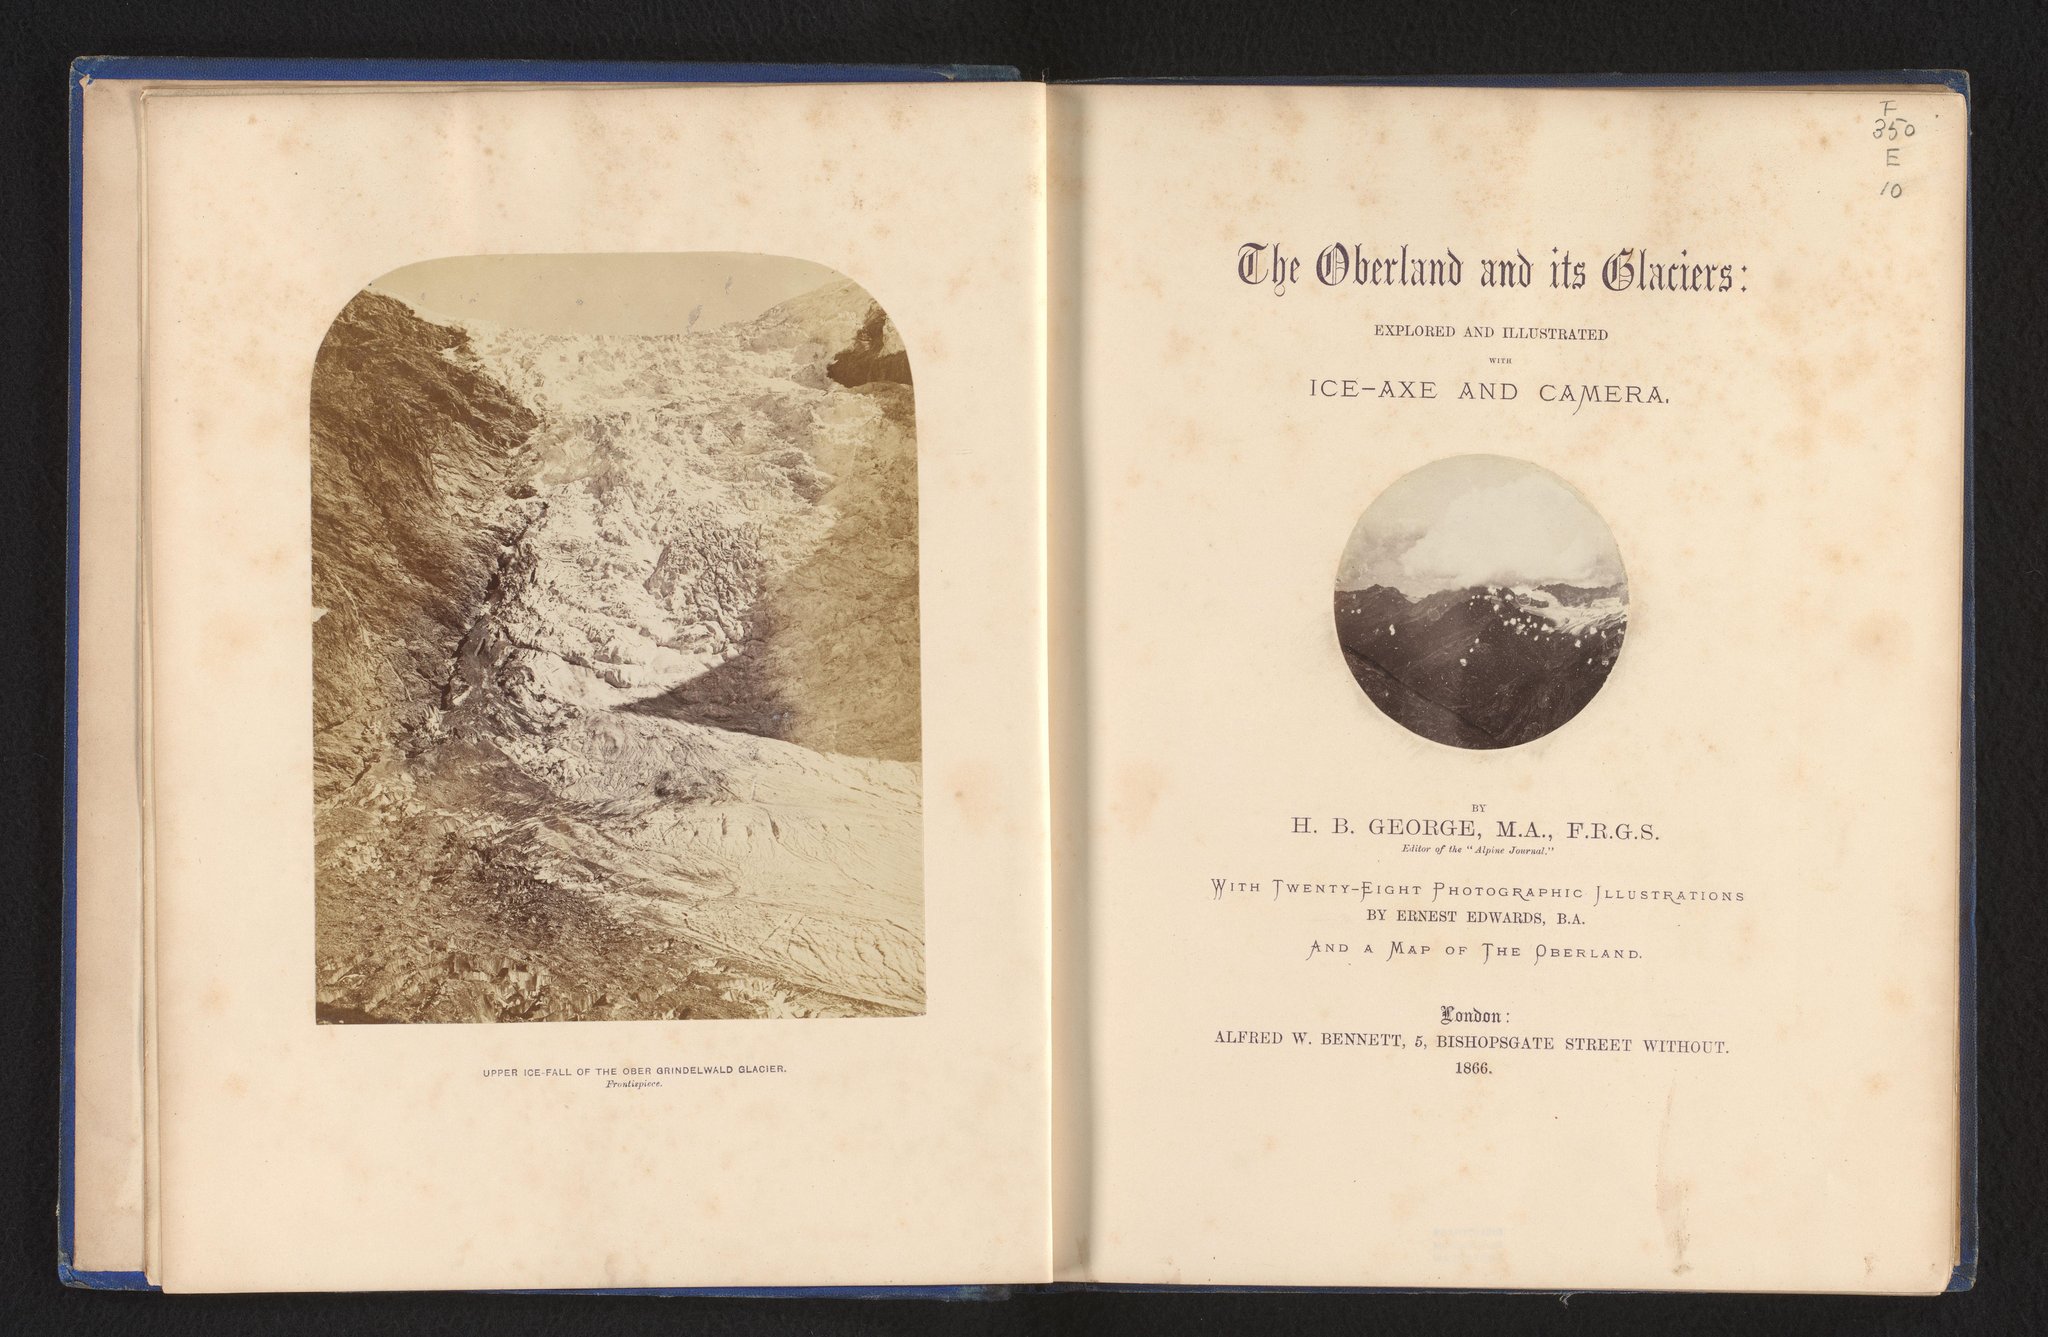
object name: book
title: The Oberland and its glaciers : explored and illustrated with ice-axe and camera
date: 1866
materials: cardboard, linen, paper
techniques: albumen print, printing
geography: london